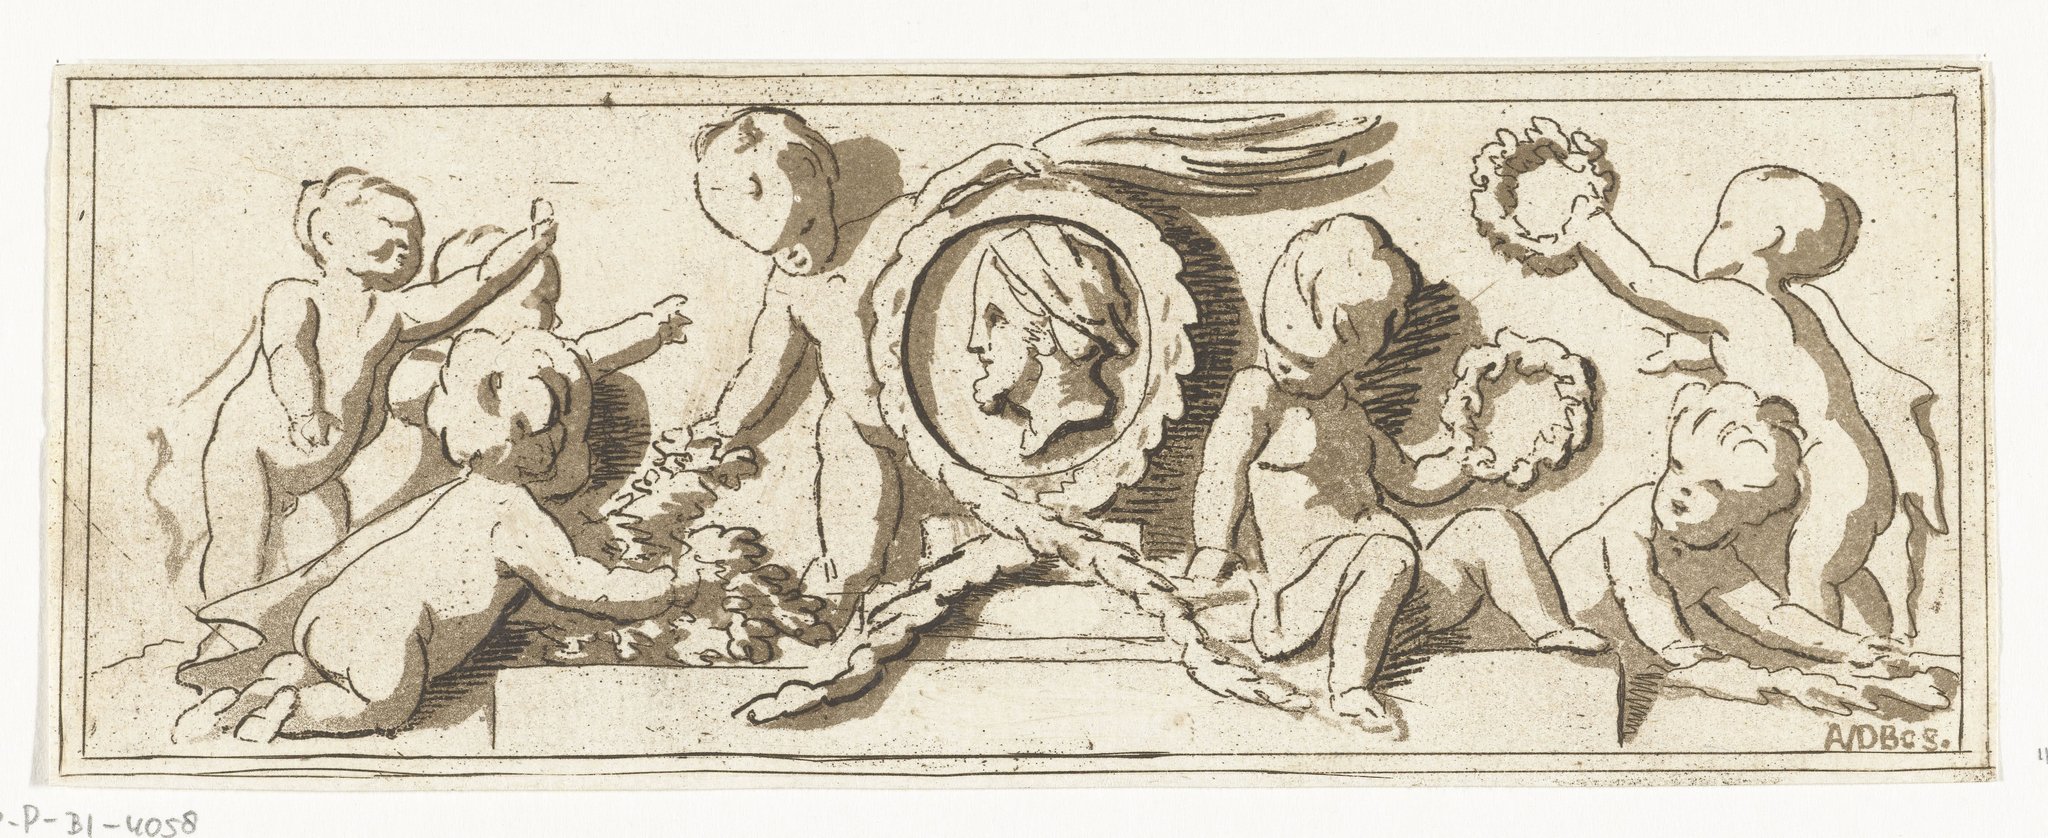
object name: print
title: Fries met putti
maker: anthonie van den bos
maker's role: draughtsman, print maker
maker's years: 1763-1838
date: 1778-1838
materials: paper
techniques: aquatint, etching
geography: netherlands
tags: cupids: 'amores', 'amoretti', 'putti'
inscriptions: collector's mark: Lugt 2228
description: Zeven putti met bloemenkransen op een fries. In het midden een medaillon met een mannenportret en profiel.